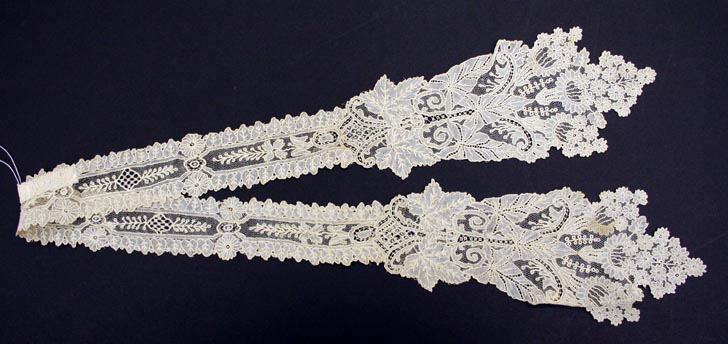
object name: necktie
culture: european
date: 1860-1865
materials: linen